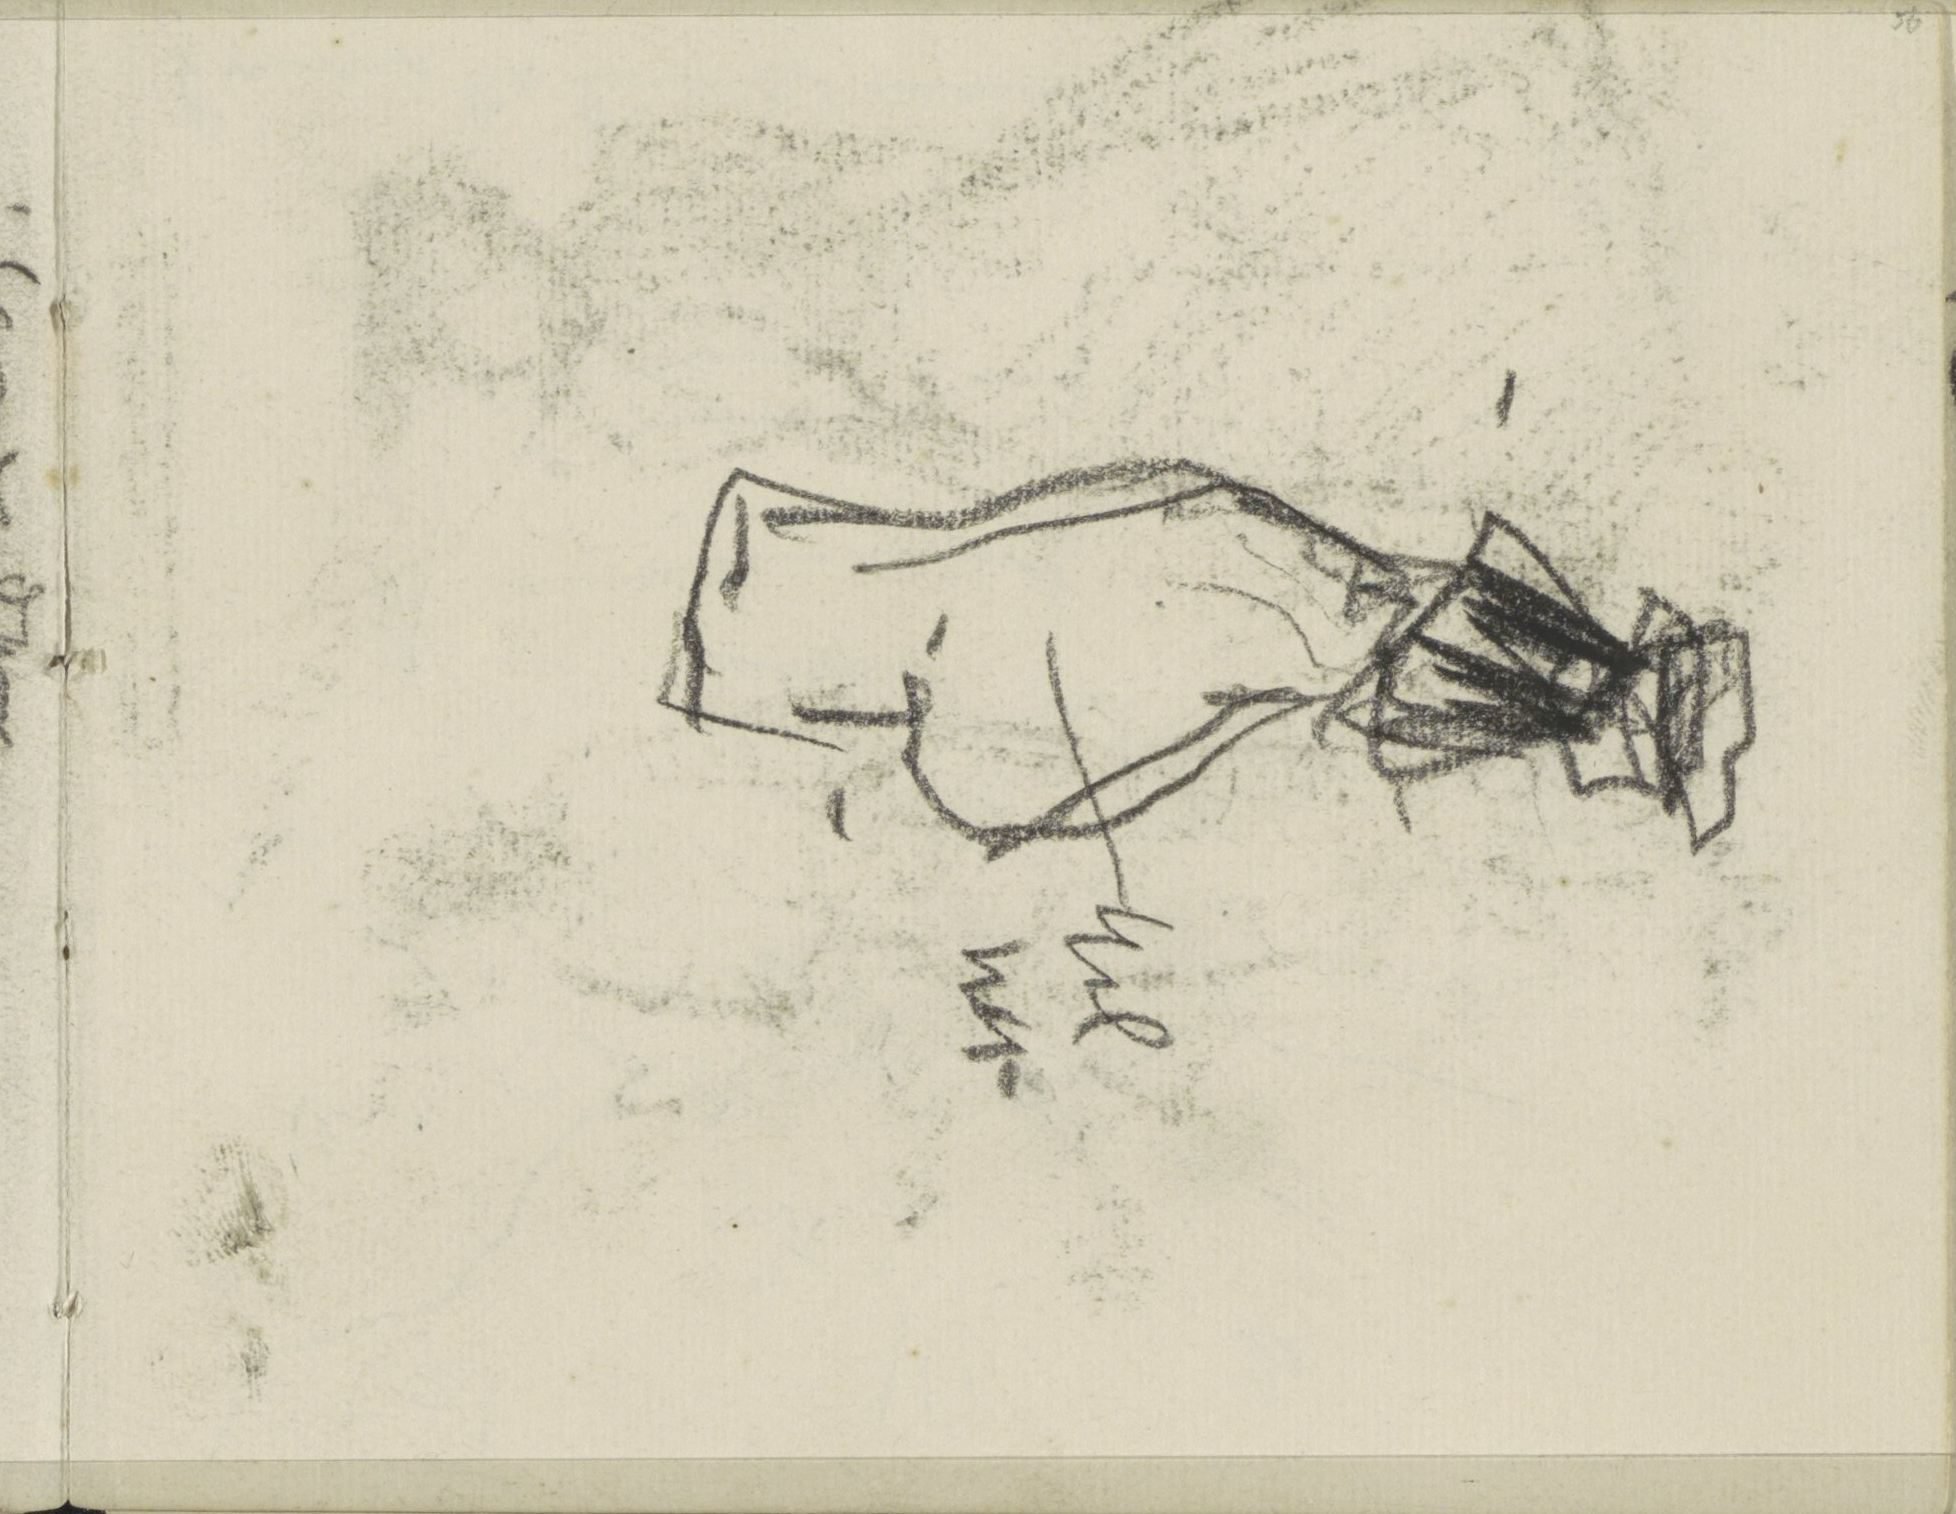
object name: sketchbook leaf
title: Vrouw met hoed, mogelijk op de Dam te Amsterdam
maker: george hendrik breitner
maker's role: draughtsman, painter, print maker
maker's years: 1857-1923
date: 1893-1912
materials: chalk, paper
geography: amsterdam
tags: adult woman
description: Pagina 56 uit een schetsboek met 32 bladen.